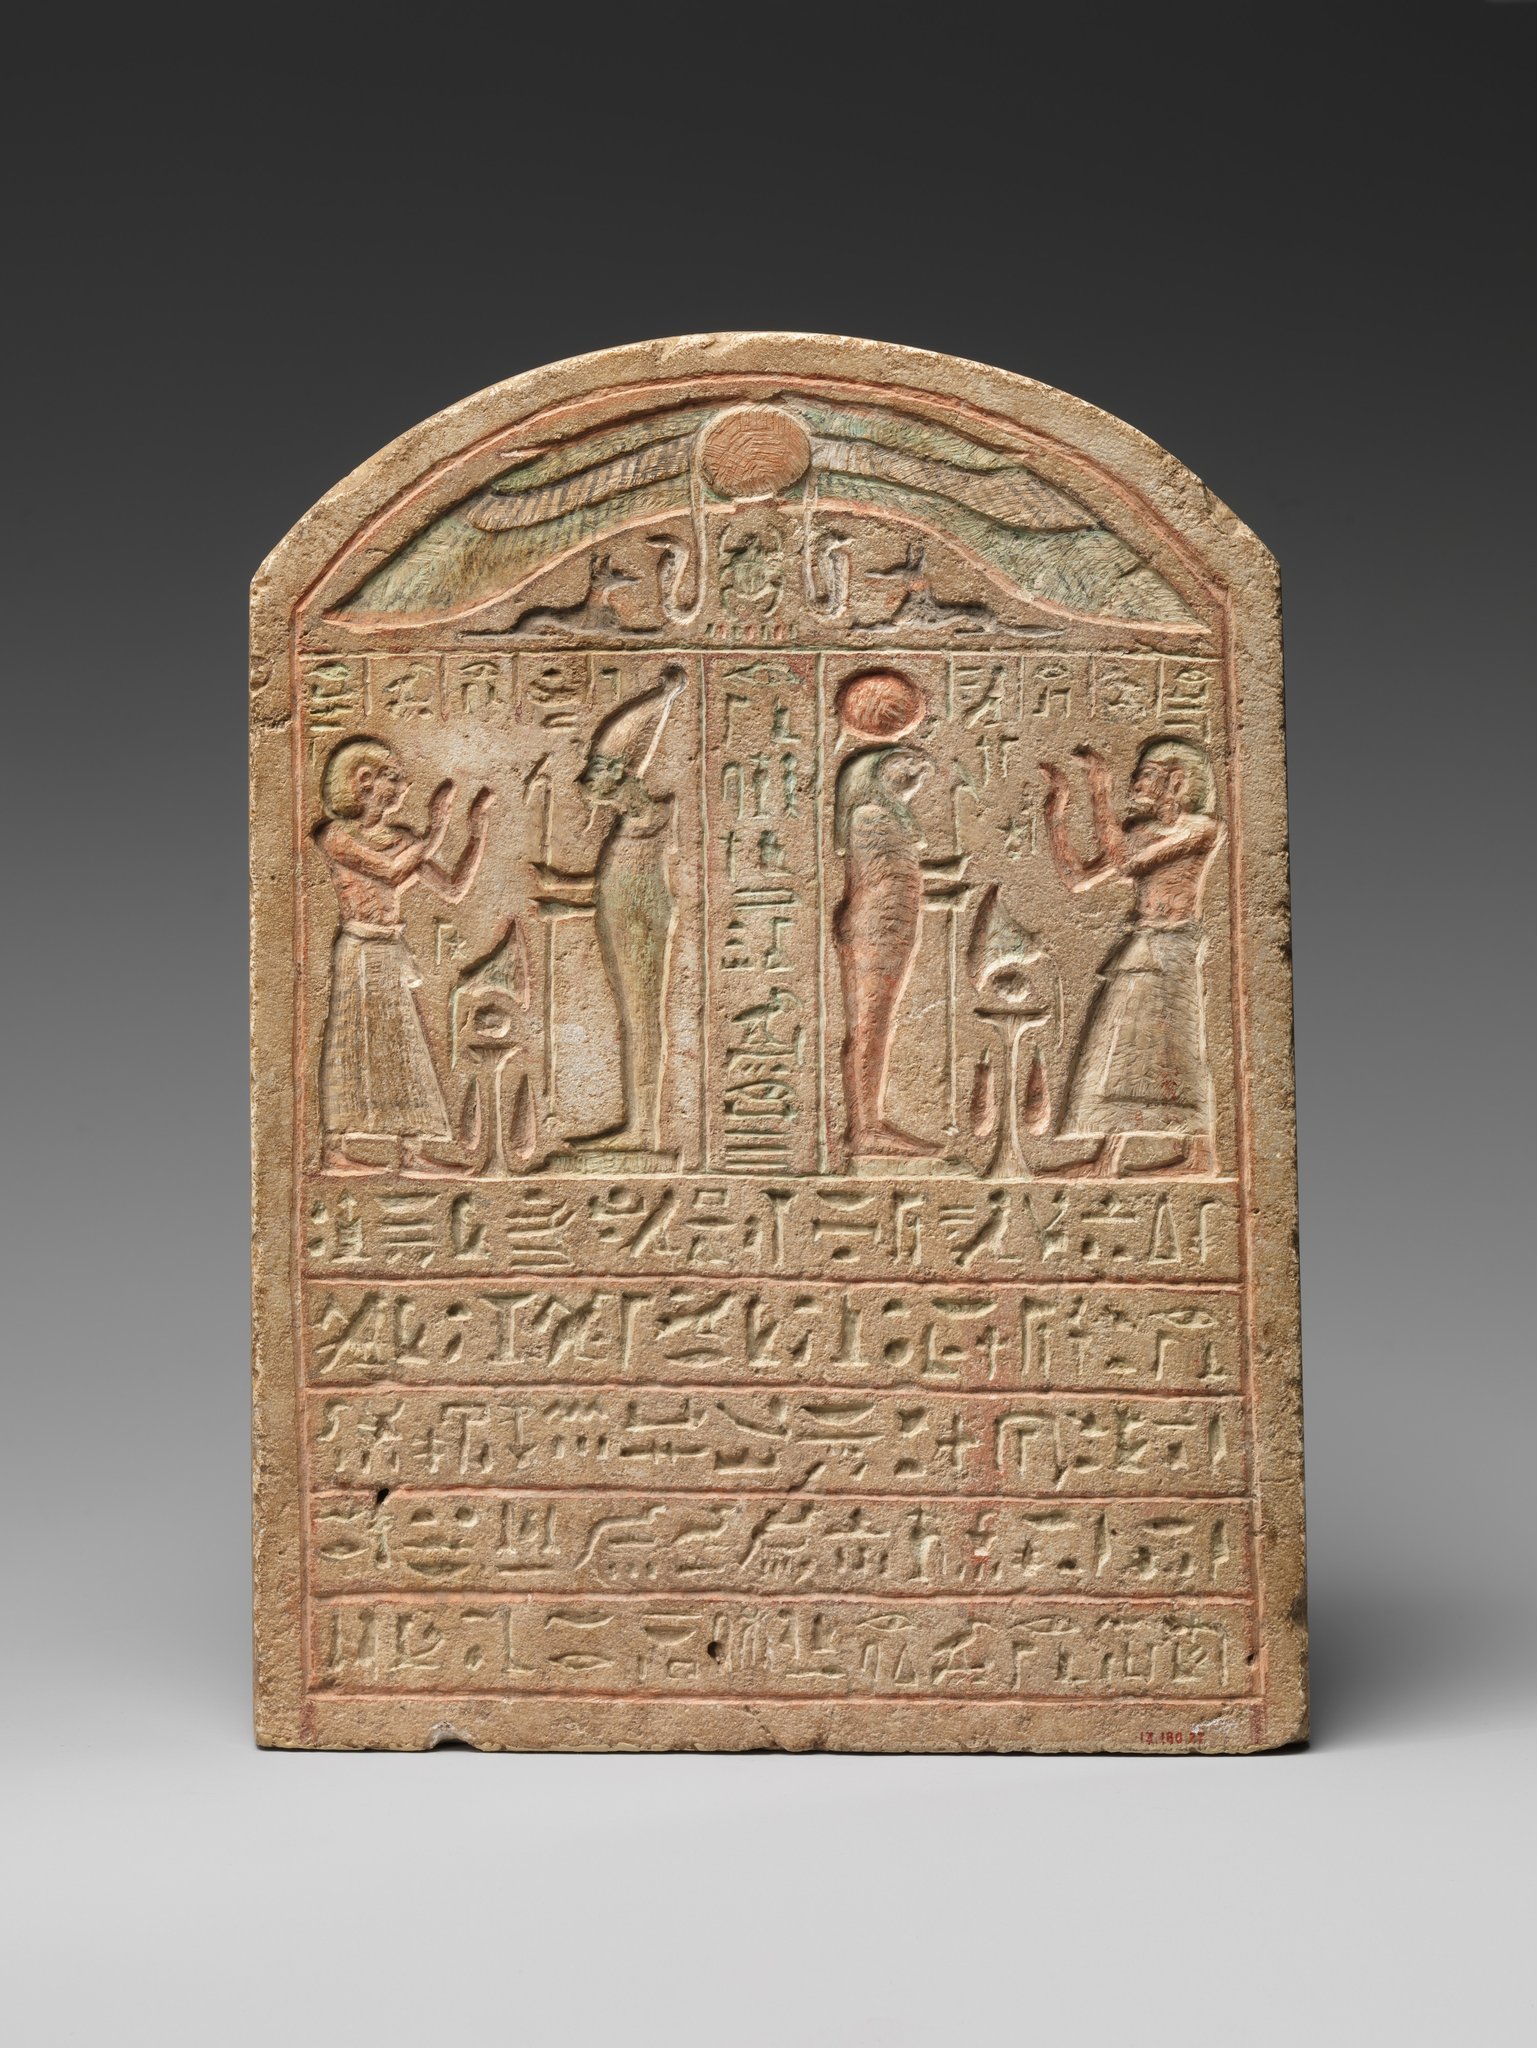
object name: stela, thutirtis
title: Funerary stela of Thutirtis, born of Kerbet (?)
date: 350-300 BCE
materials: limestone, paint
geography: egypt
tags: hieroglyphs